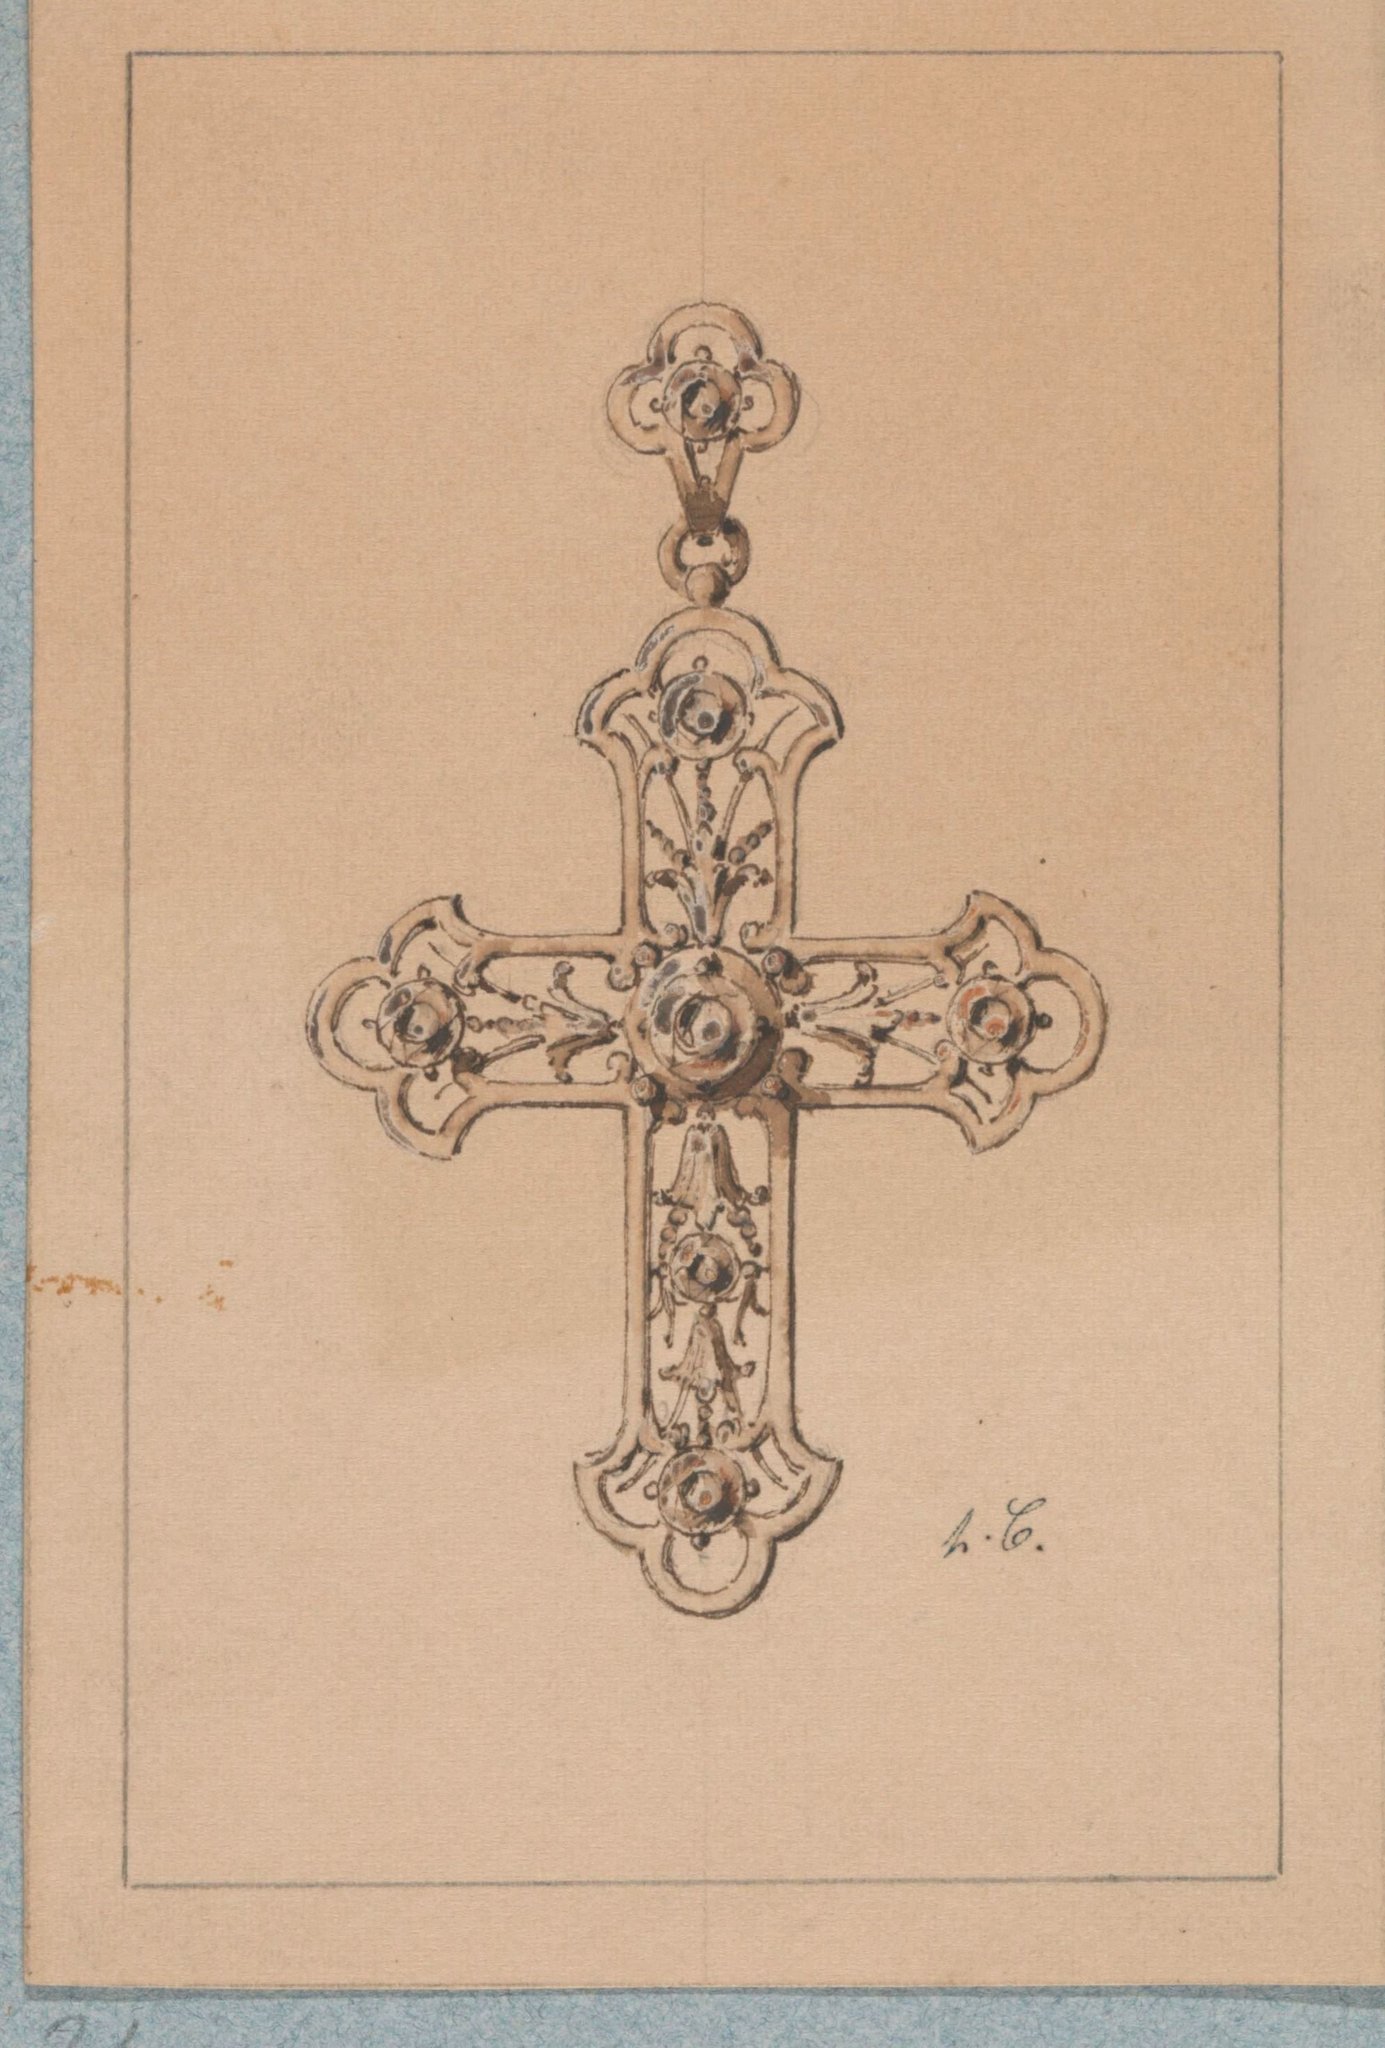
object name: design drawing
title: Two Designs for Pendants with Diamonds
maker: henri cameré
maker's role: designer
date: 1864-1894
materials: paint, ink, paper, watercolor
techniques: pen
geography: paris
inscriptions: signature: ‘h.C.’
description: In 1867 rich diamond deposits were discovered along the Orange River in South Africa. Diamonds subsequently flooded the European market. Their price went down, and they became more widely available and affordable than in previous centuries. Notice the three drop-shaped diamonds hanging from the pendant in the top drawing; this type of cut is called briolette. The cruciform pendant is set with brilliant-cut diamonds.